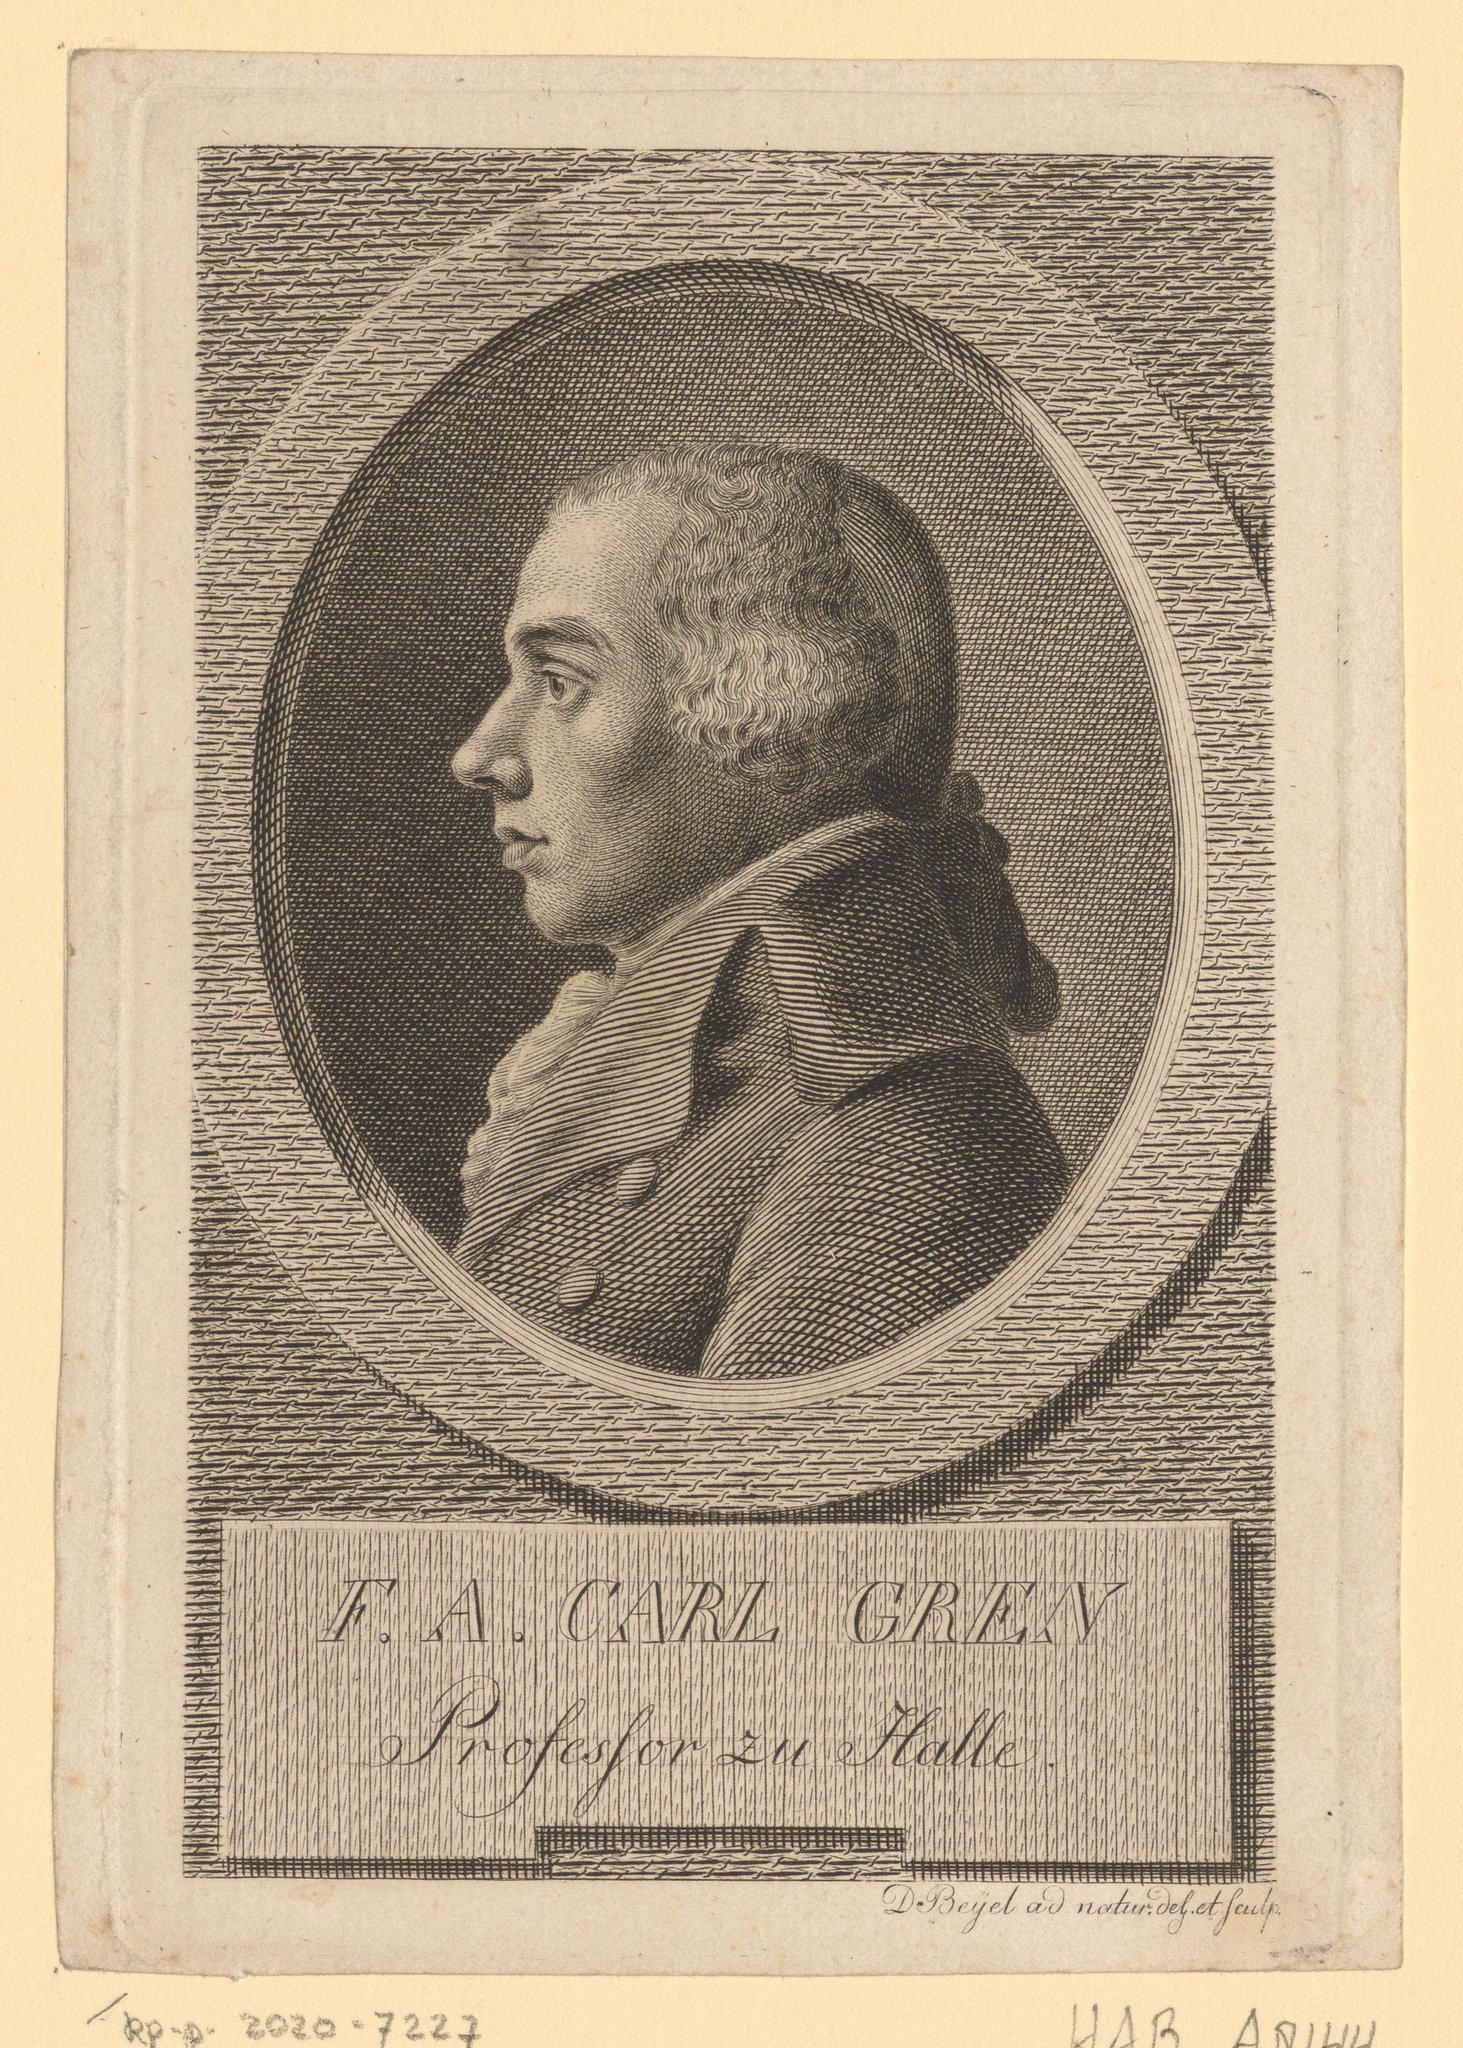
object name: book illustration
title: Portret van Friedrich Albert Carl Gren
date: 1796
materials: paper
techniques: engraving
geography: kiel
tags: chemistry (+ portrait of scholar, scientist), historical persons, professor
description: Prent uit: Neue allgemeine deutsche Bibliothek. Kiel: Carl Ernst Bohn, 1796, dl. 22.